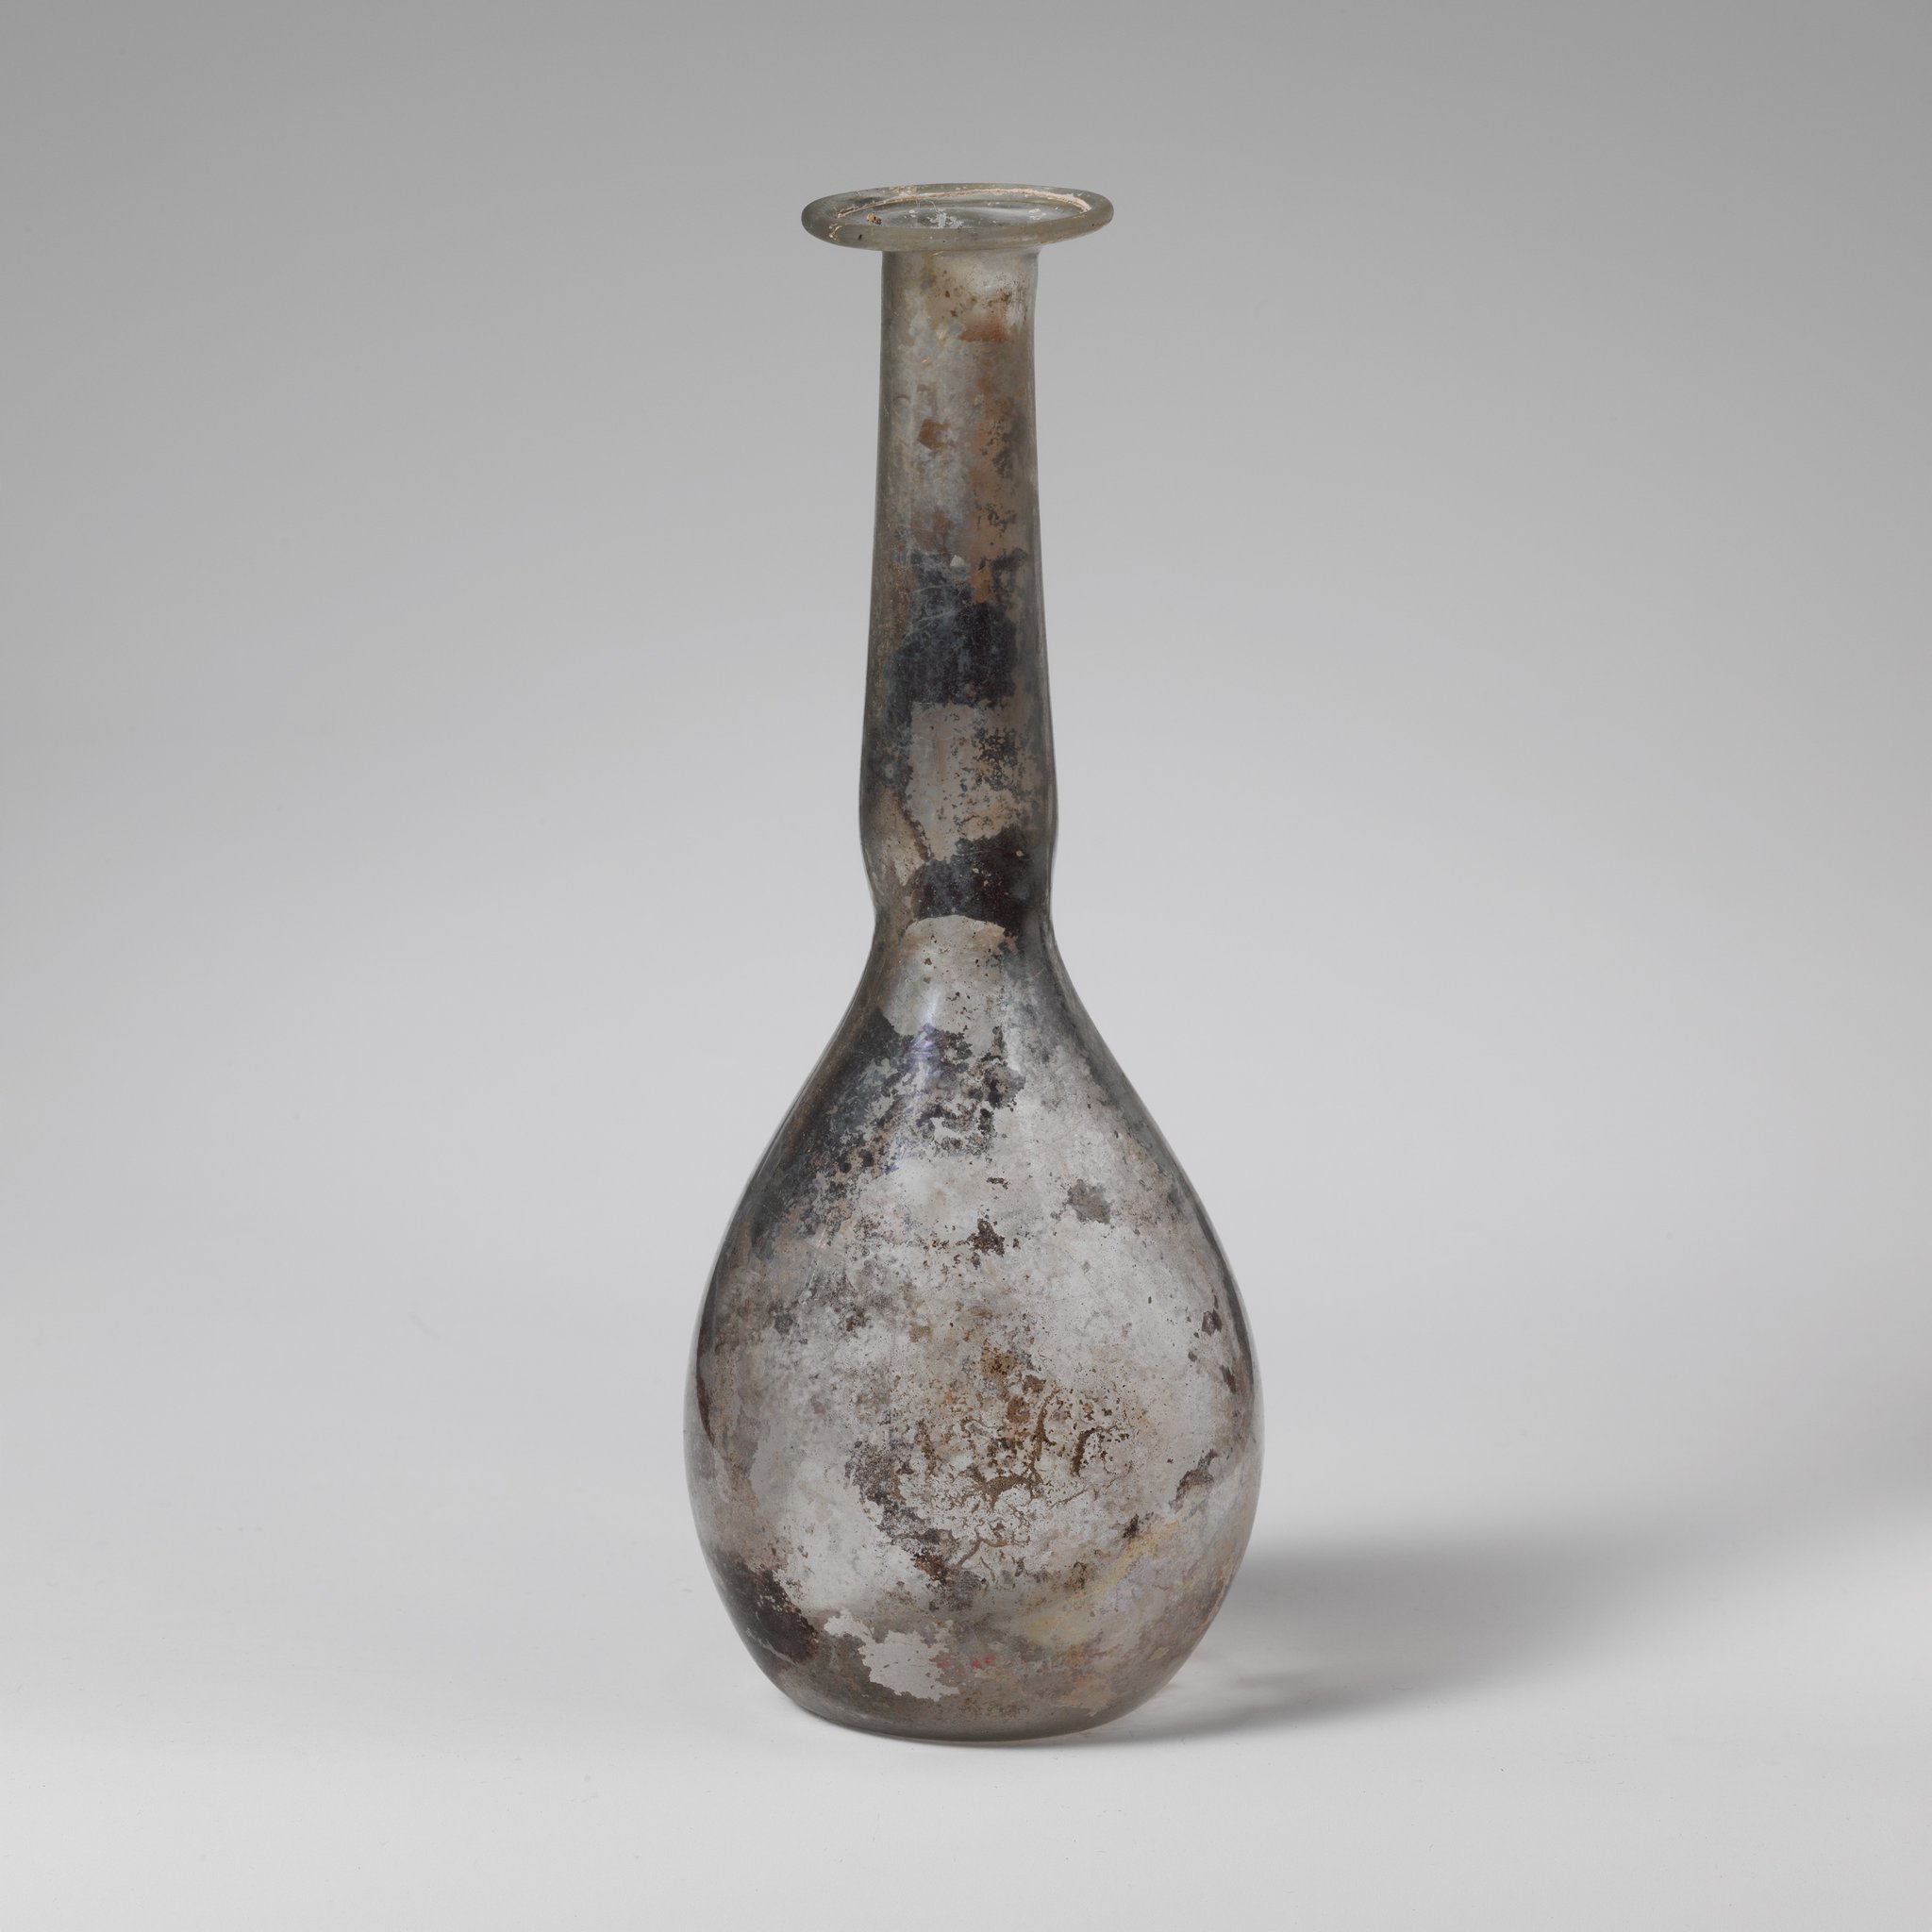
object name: perfume bottle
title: Glass perfume bottle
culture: roman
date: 101-300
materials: glass